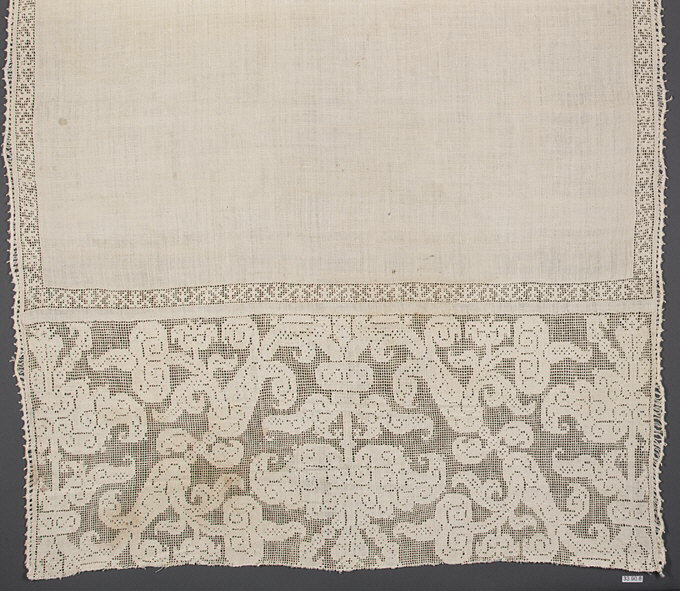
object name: scarf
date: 1501-1600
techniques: embroidery